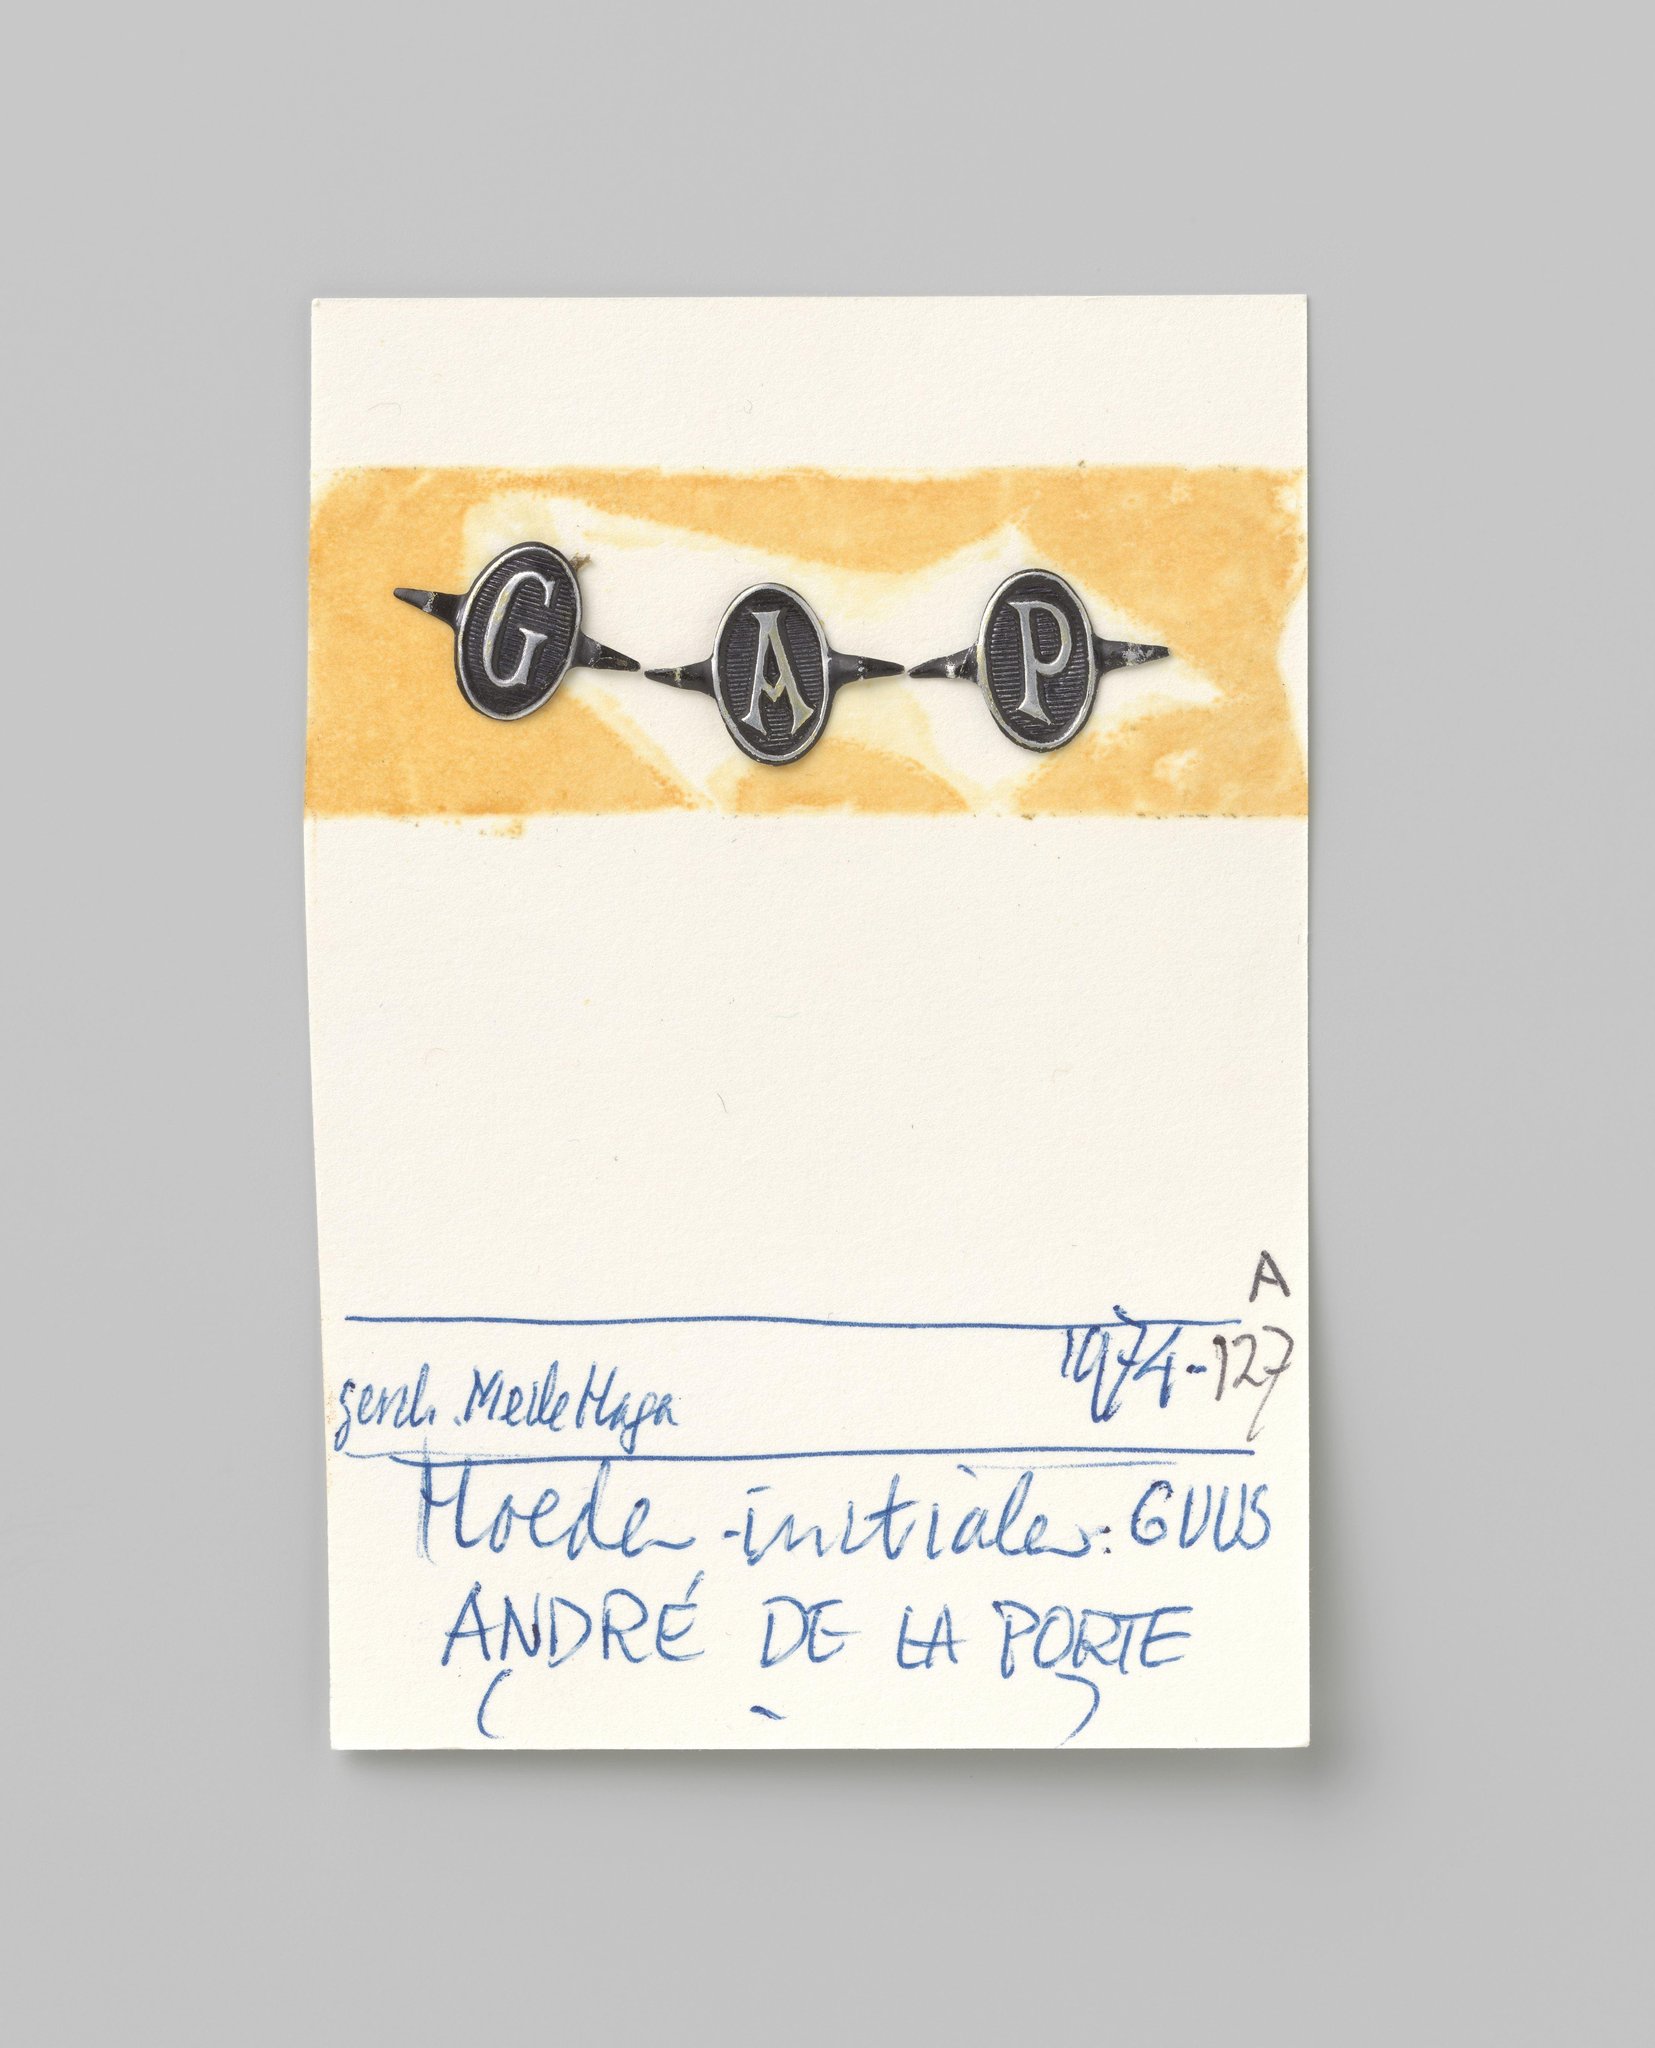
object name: part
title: Letter P om aan hoedenlint te klemmen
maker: Anonymous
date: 1850-1930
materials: metal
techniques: striking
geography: europe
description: De letter hoort bij het drietal letters G A P: Guus André de la Porte.